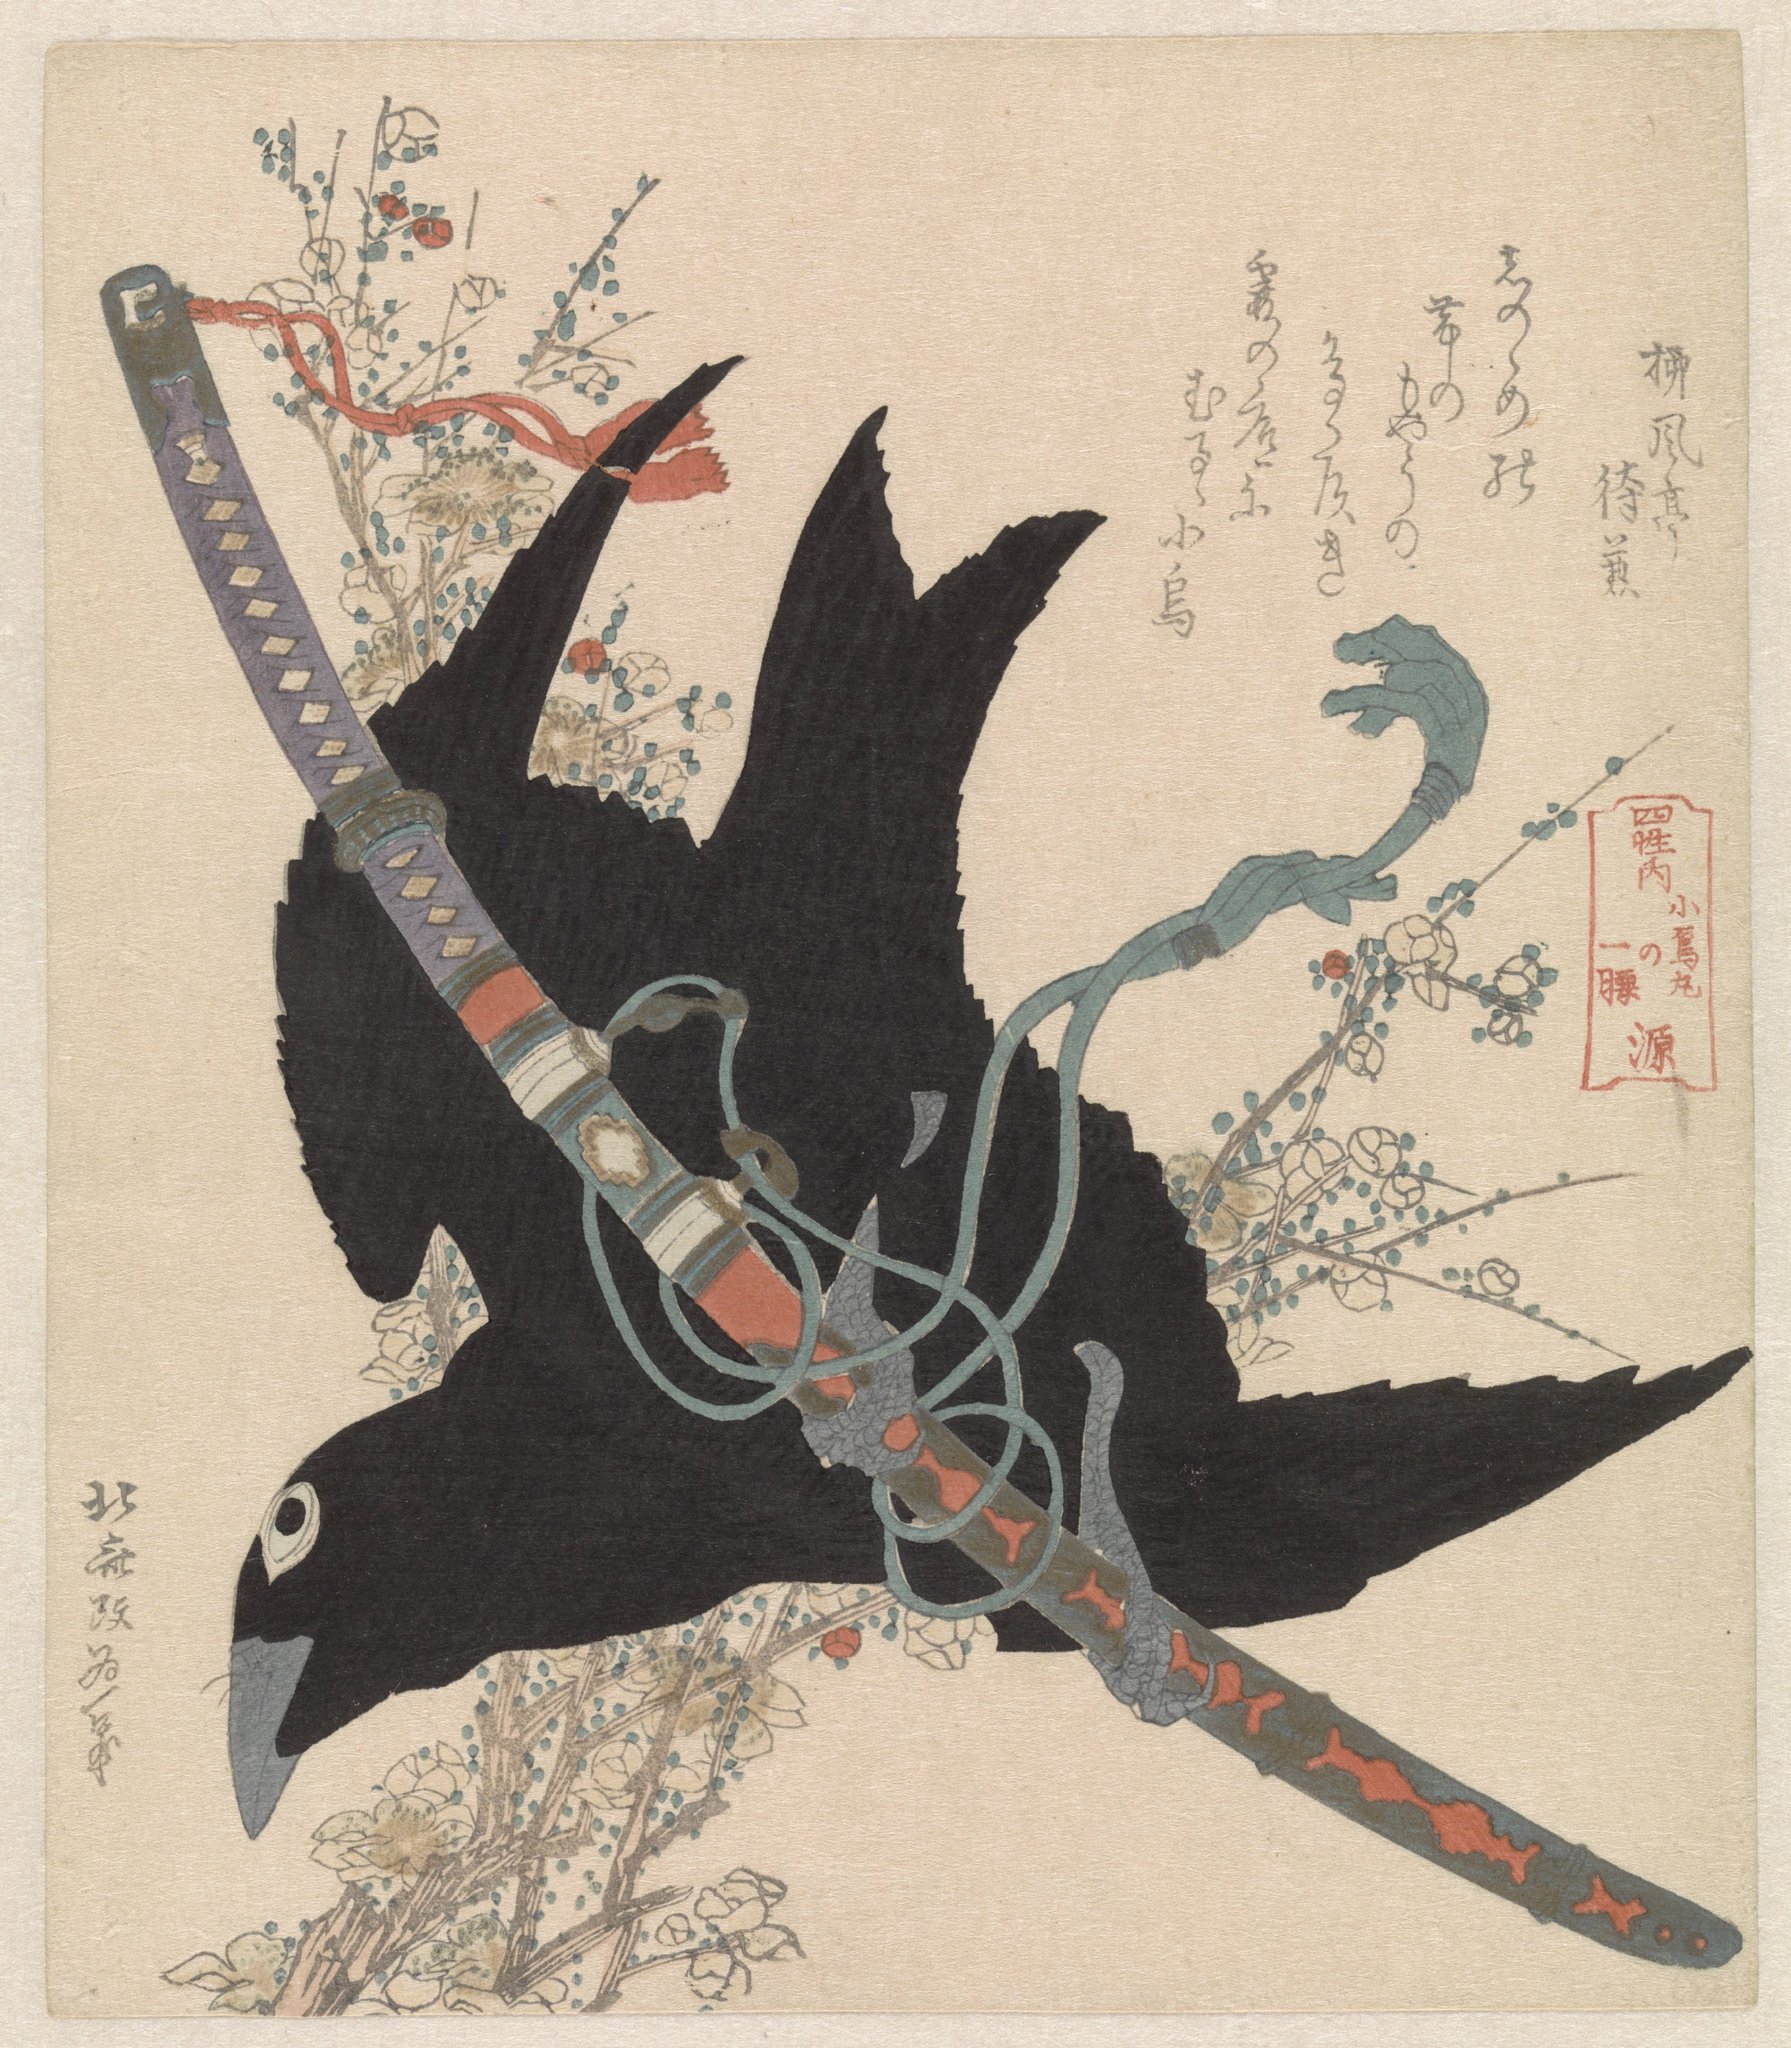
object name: surimono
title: Shisei no uchi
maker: katsushika hokusai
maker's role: draughtsman, print maker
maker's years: 1760-1849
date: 1890-1900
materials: paper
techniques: blind stamped, woodcut, polish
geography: japan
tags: song-birds: crow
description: Een surimono is een luxe uitgevoerde prent waarop beeld met één of meerdere gedichten gecombineerd is. Bij het drukken van een surimono werd vaak gebruik gemaakt van dikker papier, blinddruk en metaal pigmenten, zoals koper- en zilverpoeder. De prenten werden vaak in opdracht van dichters gemaakt en als exclusief geschenk aan vrienden en relaties gegeven.